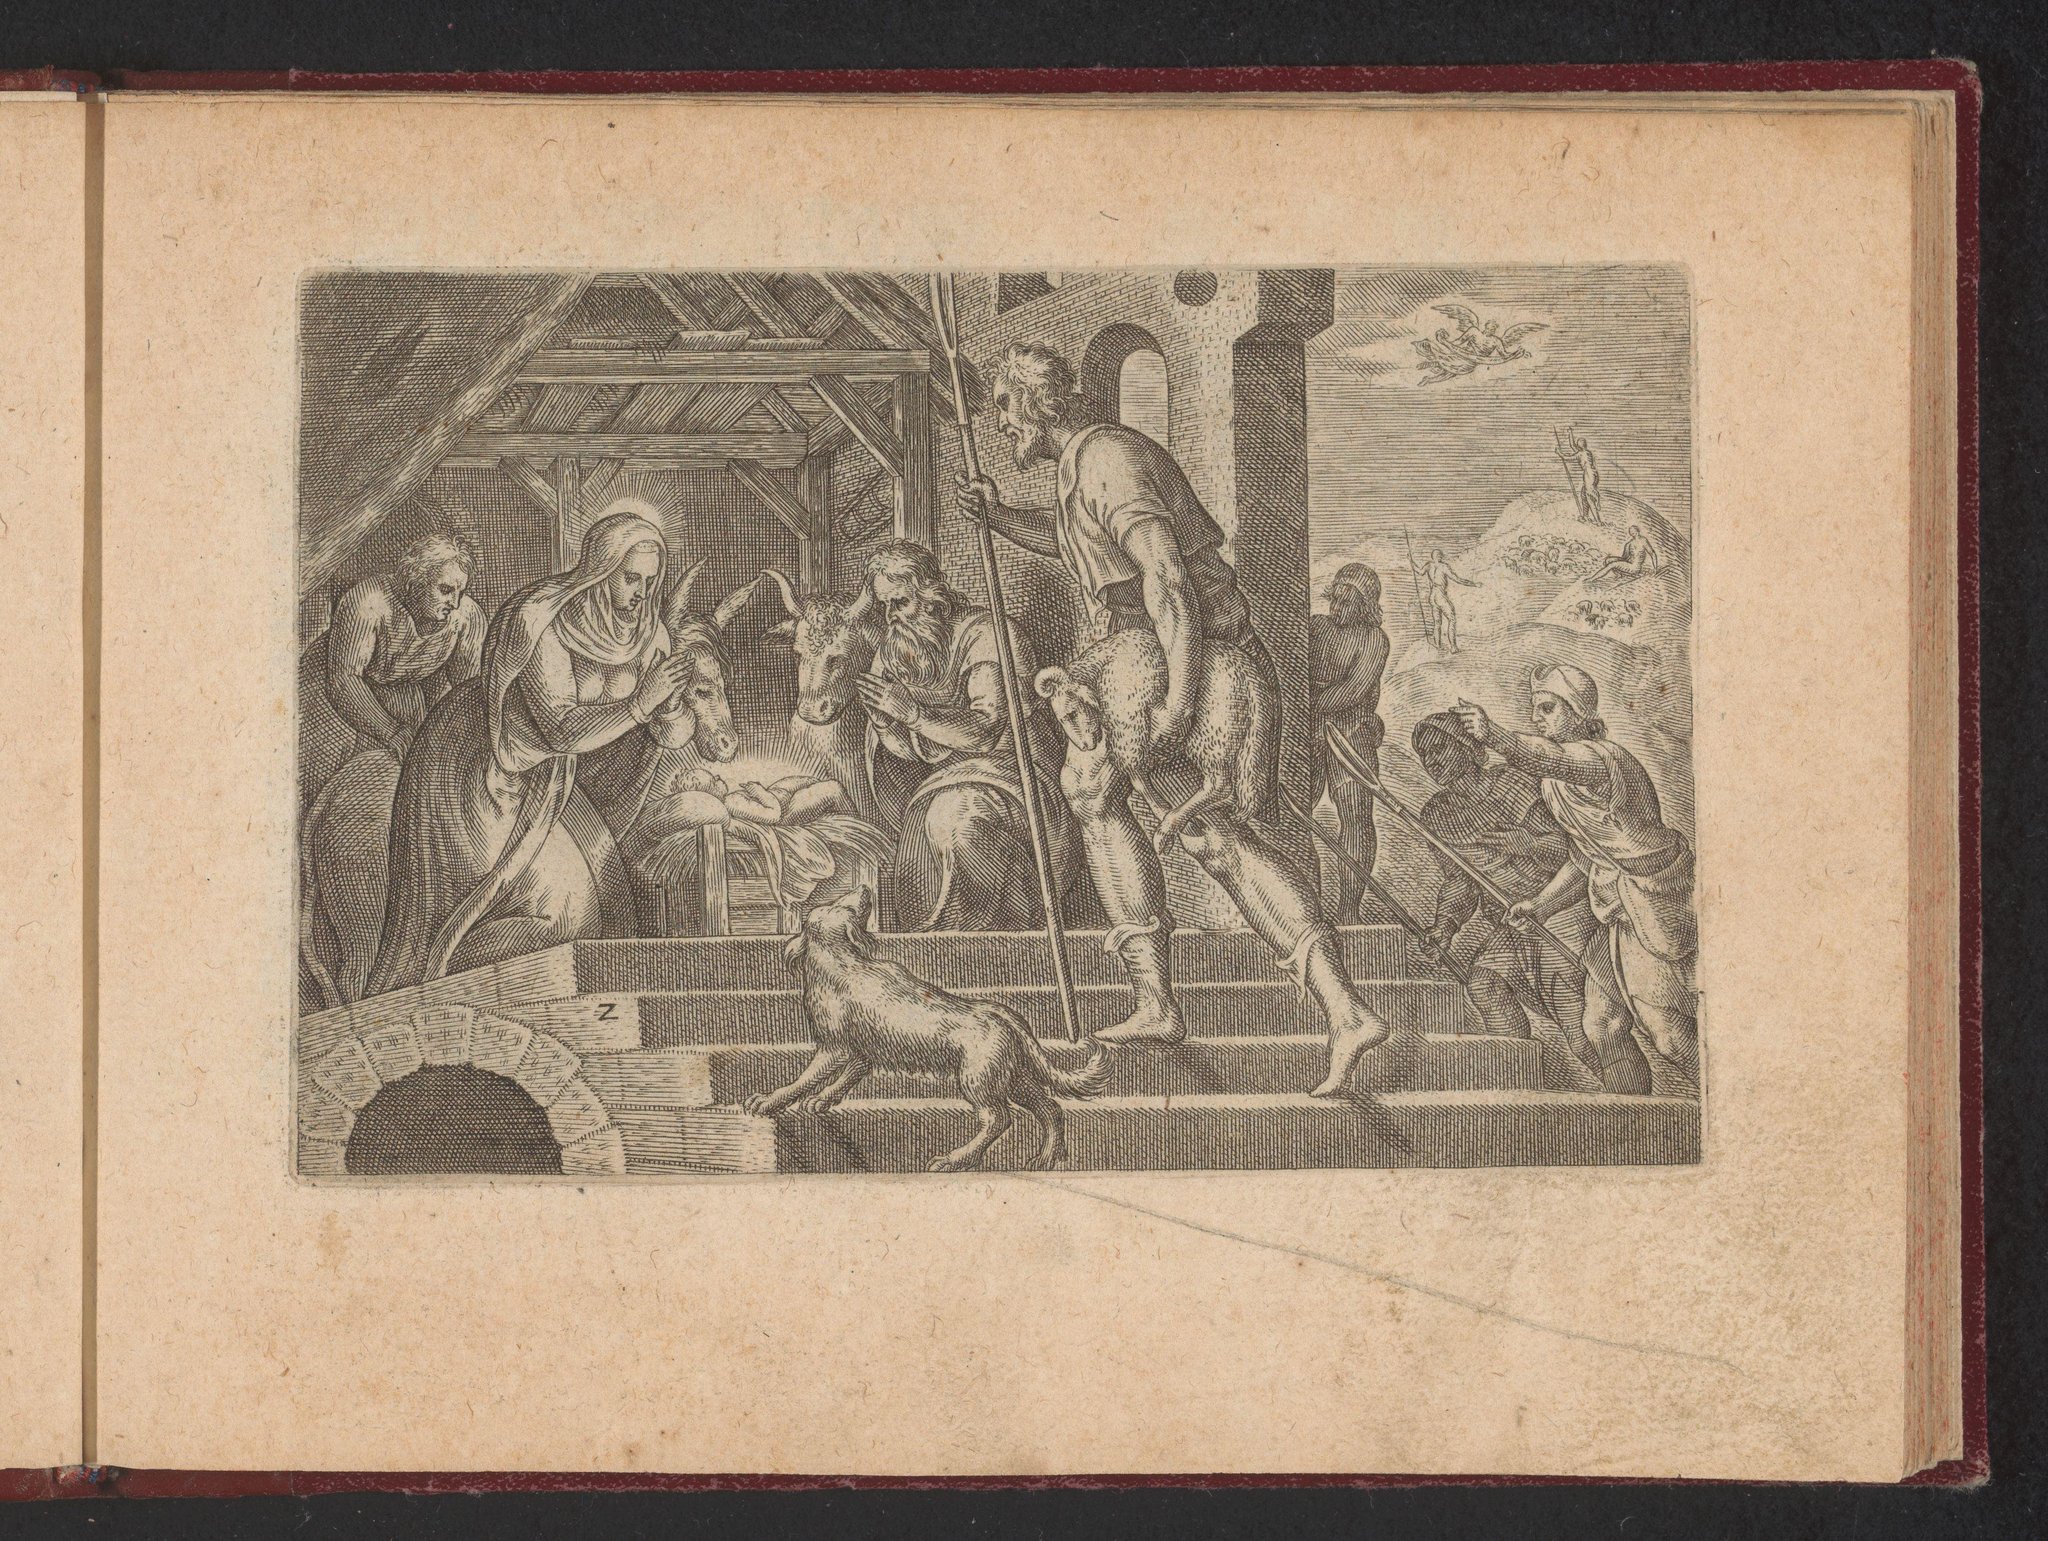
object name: print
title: Christi Iesu vitae admirabiliumque actionum speculum a Philippo Gallaeo apparatum Bened. Ariae Montani singuloribus distichis instructum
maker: philips galle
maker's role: print maker, publisher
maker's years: 1537-1612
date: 1573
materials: paper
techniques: engraving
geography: antwerp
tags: adoration of the christ-child by the shepherds; mary and joseph present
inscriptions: watermark: ‘gotische letter P’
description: Onderdeel van een album met een titelprent en een serie van 50 prenten betreffende het leven en de passie van Christus.